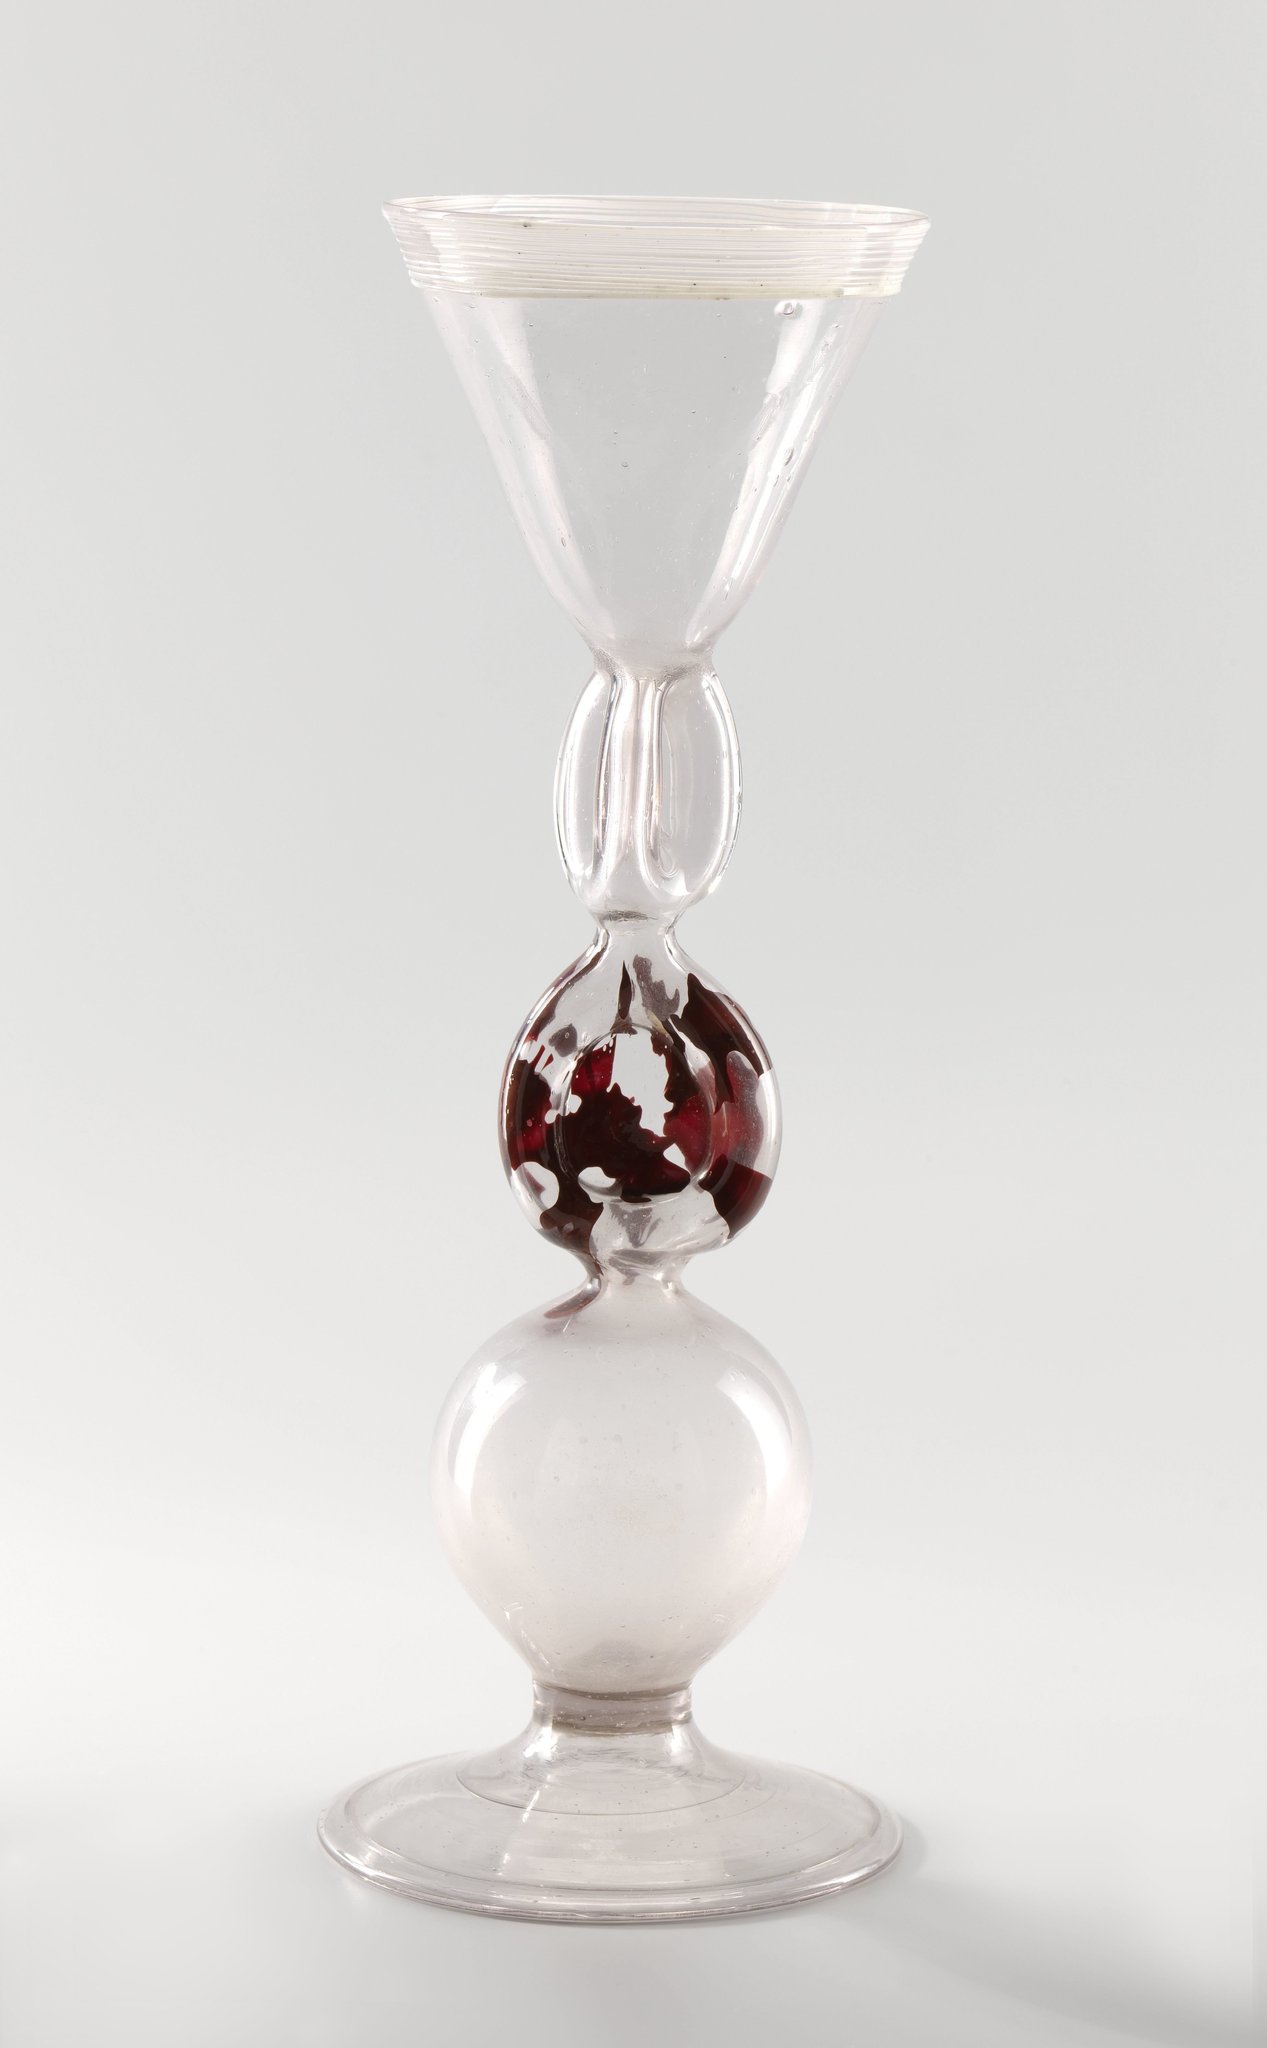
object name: goblet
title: Kelkglas met een holle stam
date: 1550-1600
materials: glass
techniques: façon de venise, glassblowing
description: Licht conische voet met omgeslagen rand. De holle stam, die in open verbinding staat met de kelk, is opgebouwd uit een bol, een cirkelvormige buis met gesloten middenveld en een verbindingsstuk bestaande uit drie dunne gebogen buisjes. Trechtervormige kelk waaromheen langs de rand een witte spiraaldraad. Aan de binnenzijde van de cirkelvormige buis en op het middenveld steenrode plekken.